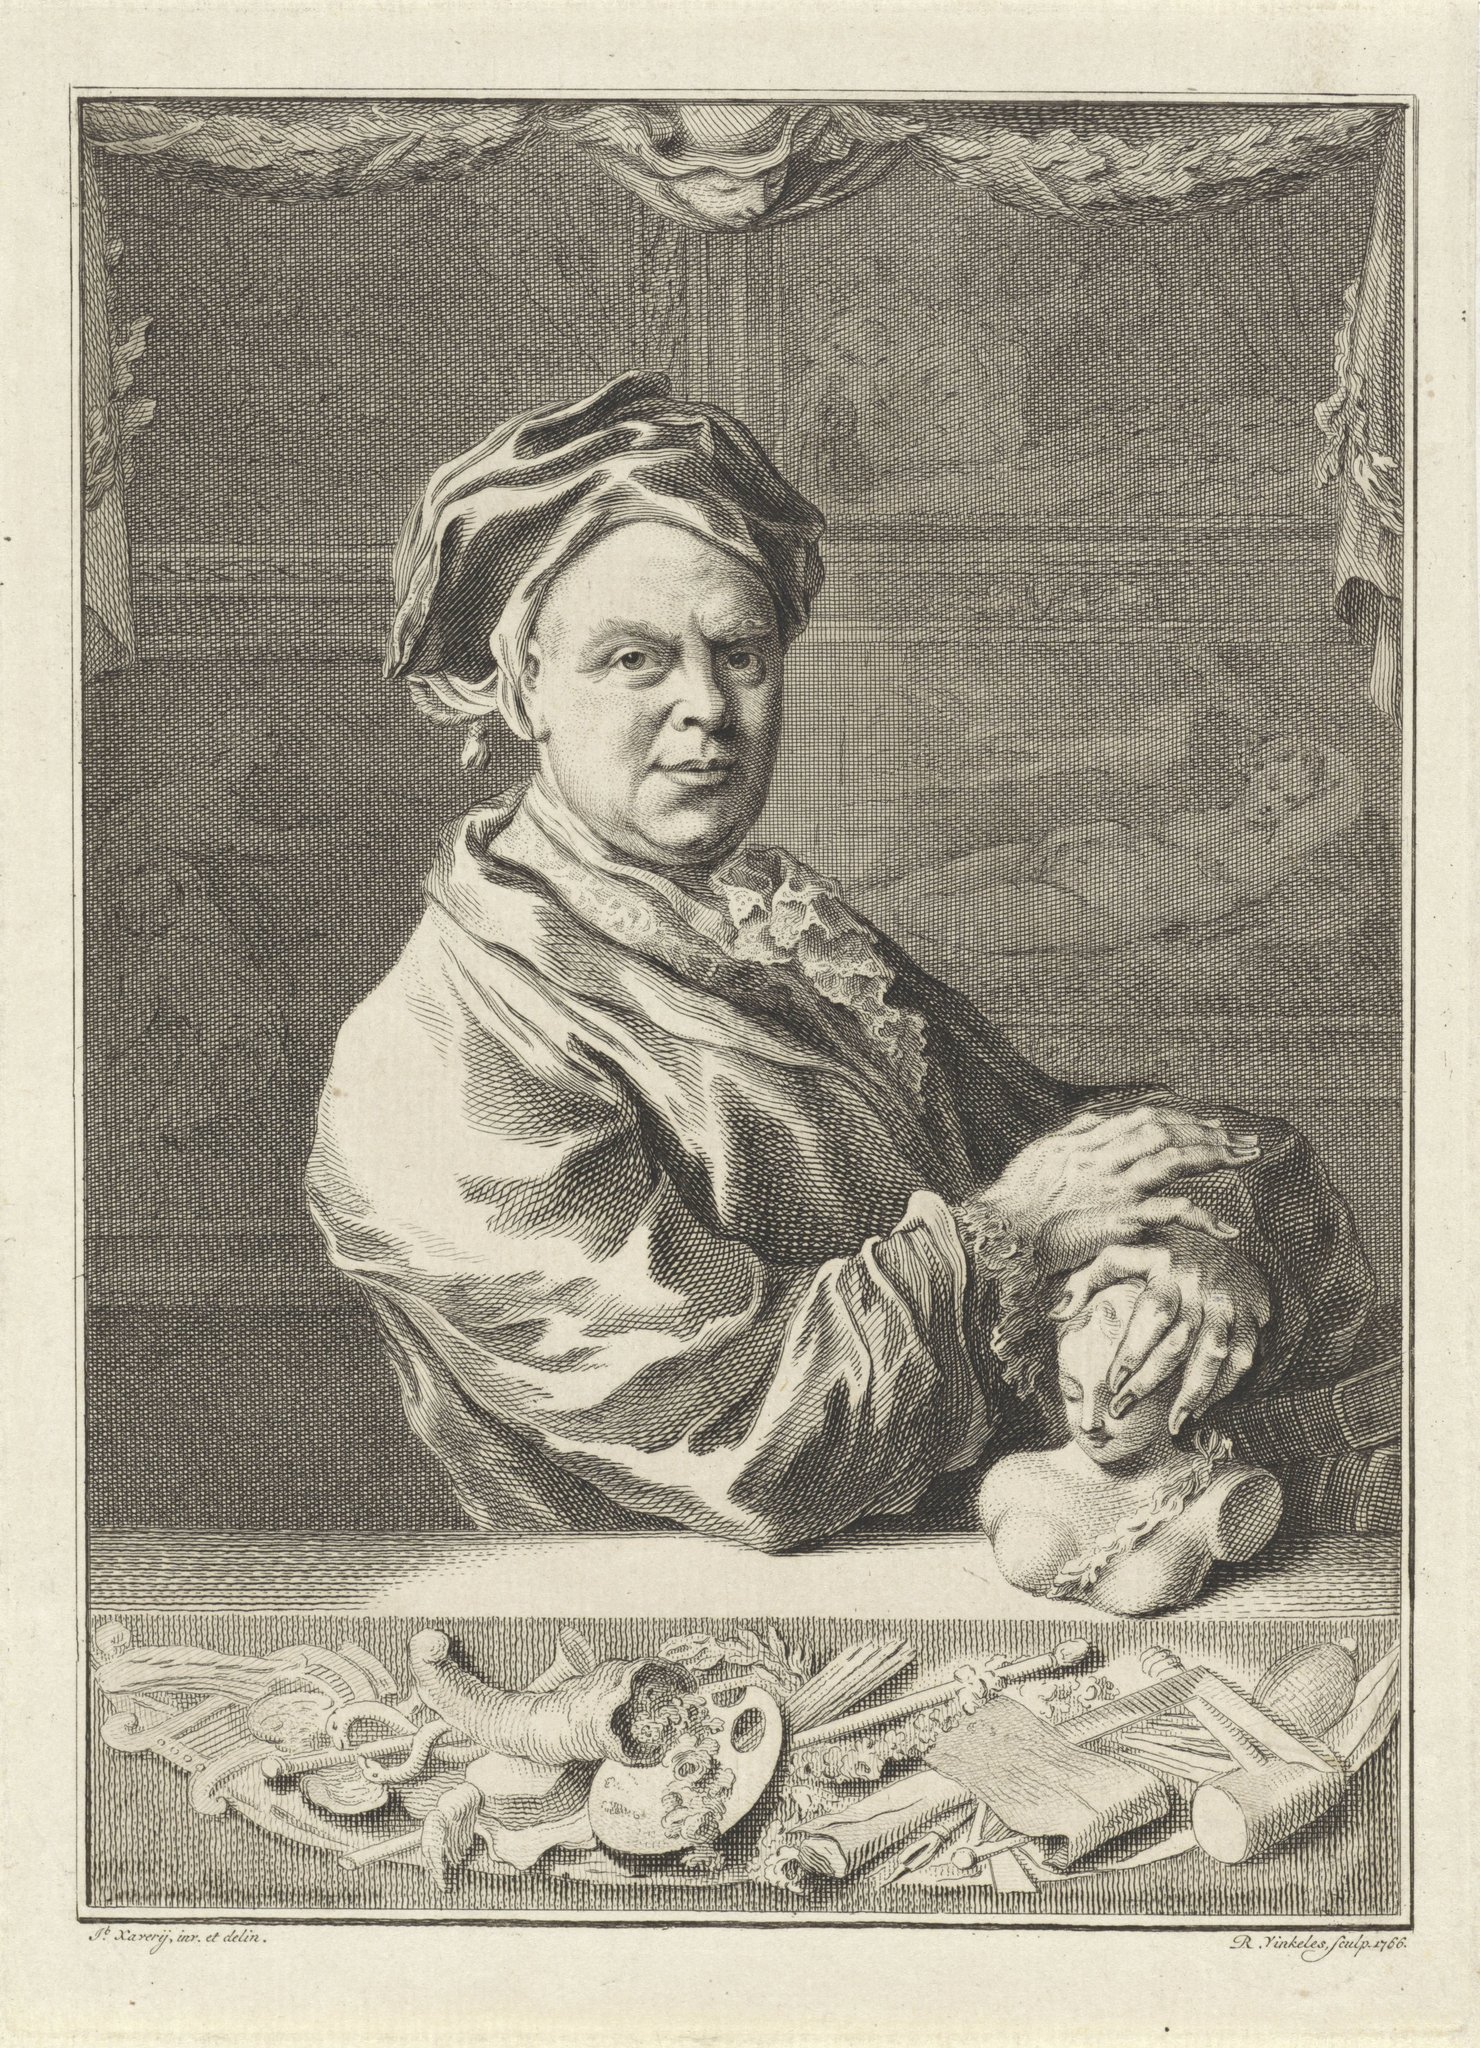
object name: print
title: Portret van Gerrit Braamcamp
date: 1766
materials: paper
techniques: engraving, etching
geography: amsterdam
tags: gerret braamcamp, piece of sculpture, reproduction of a piece of sculpture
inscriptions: collector's mark: Lugt 240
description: Portret van de Amsterdamse kunstliefhebber Gerrit Braamcamp.